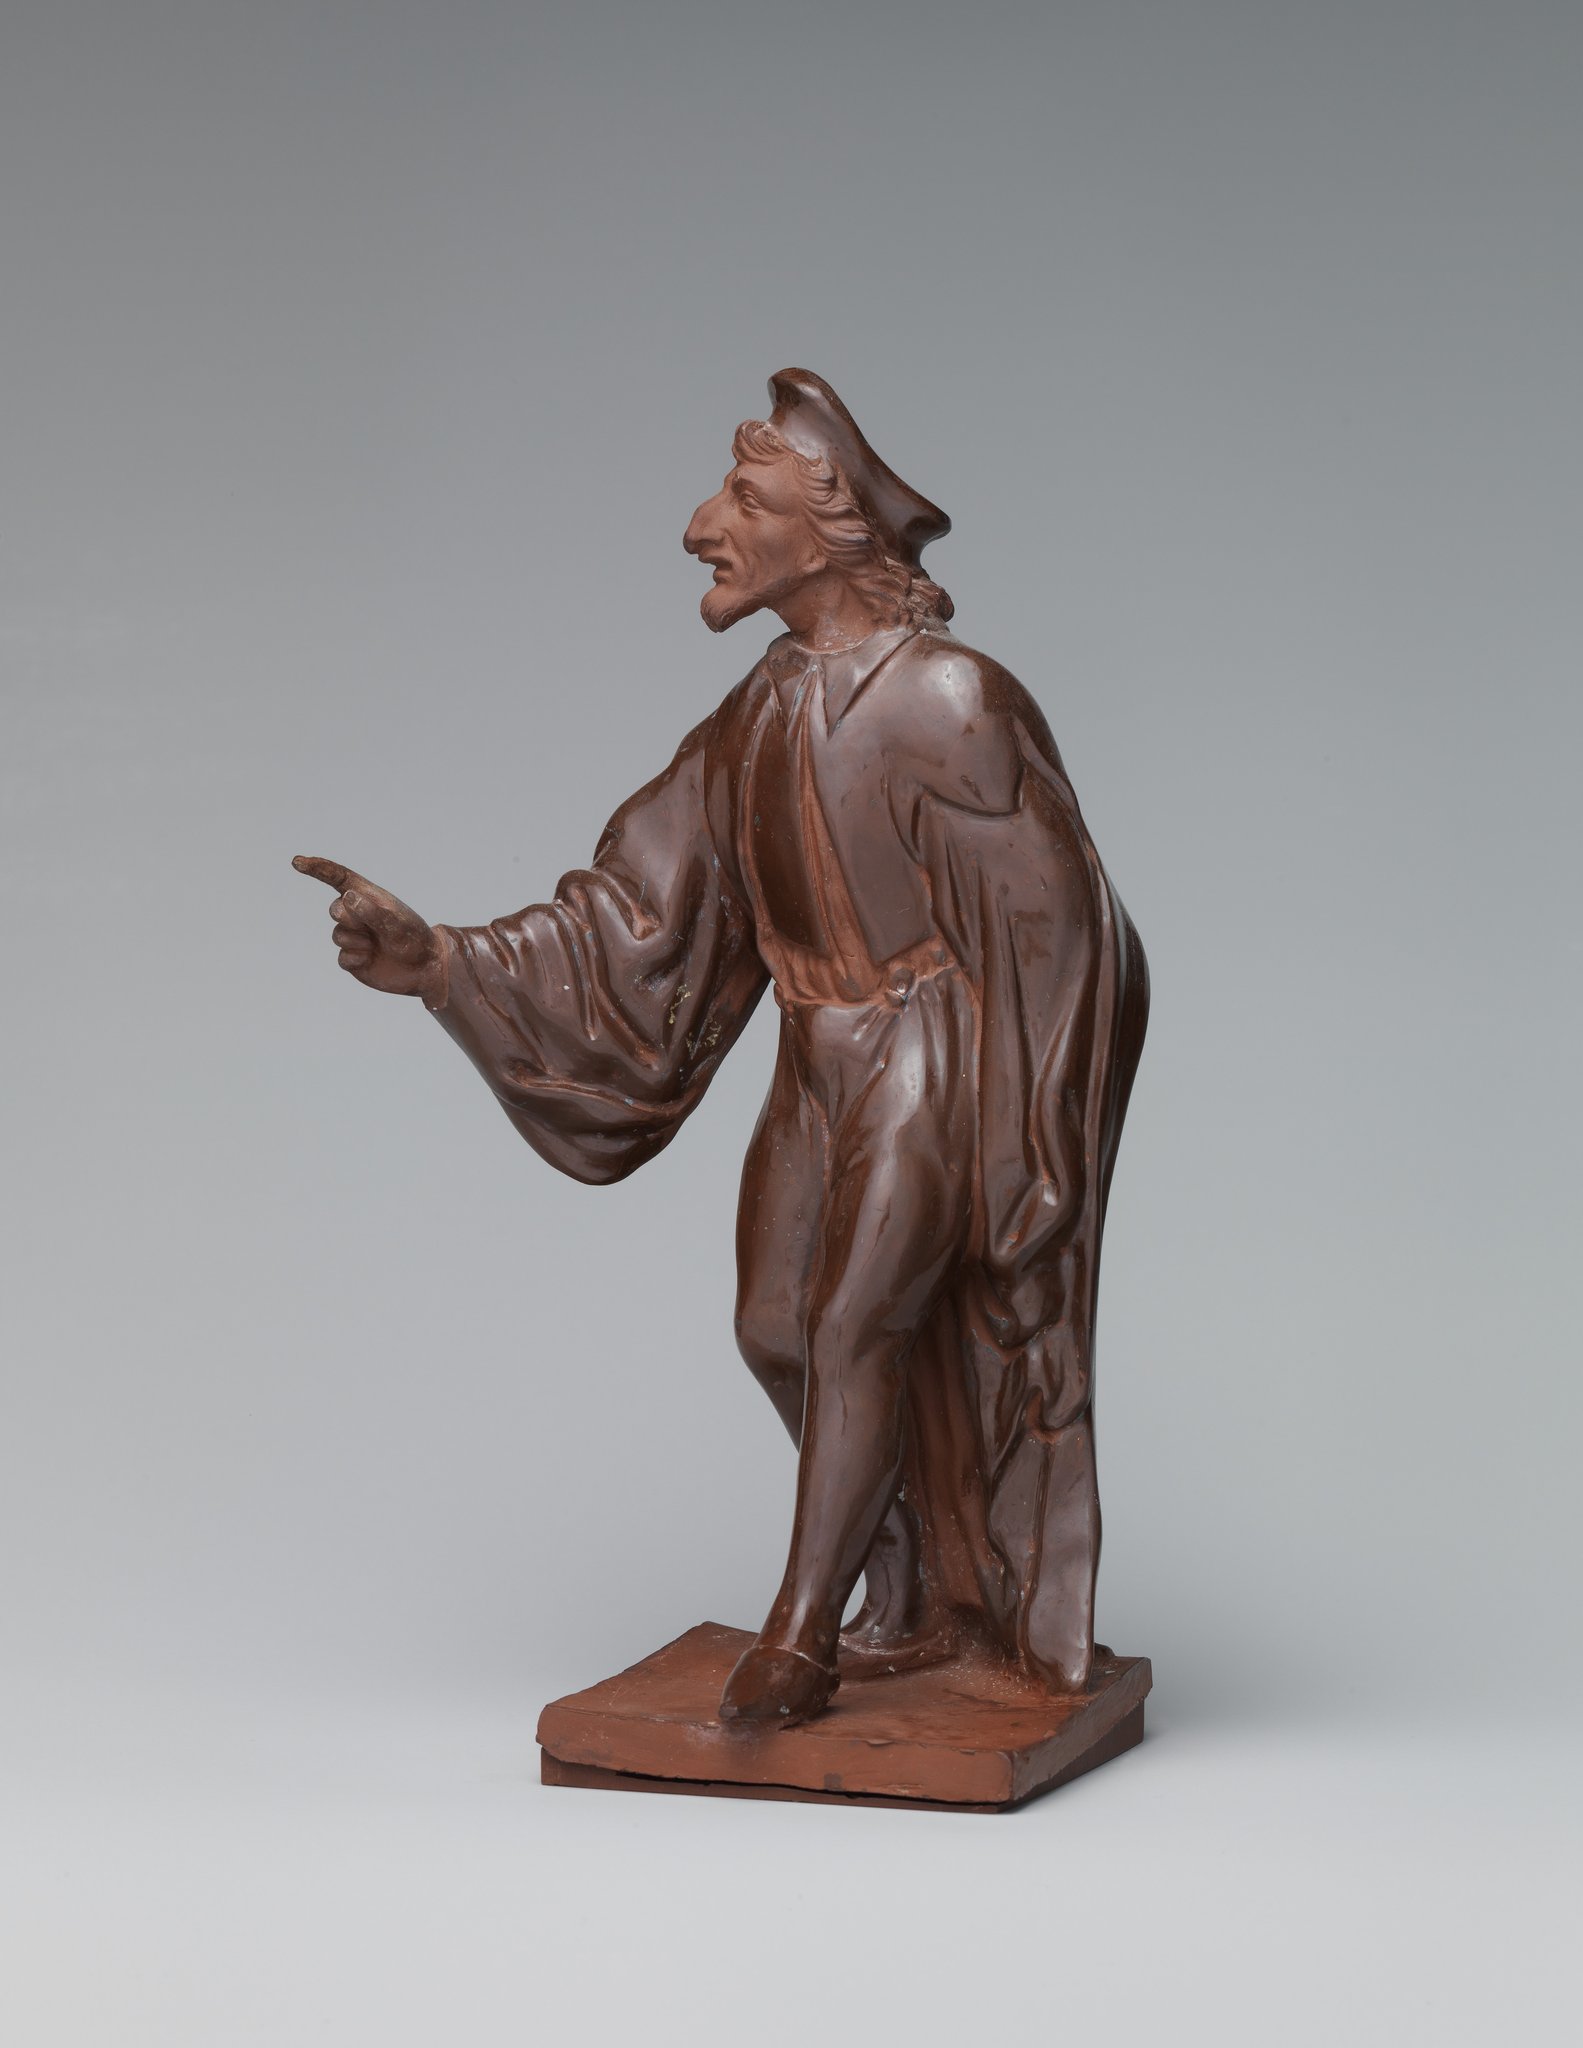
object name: figure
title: Pantaloon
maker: meissen manufactory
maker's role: manufactory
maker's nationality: german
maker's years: 1710-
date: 1710-1713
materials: stoneware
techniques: polish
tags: men